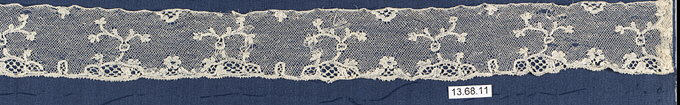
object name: fragment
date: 1801-1833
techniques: lace